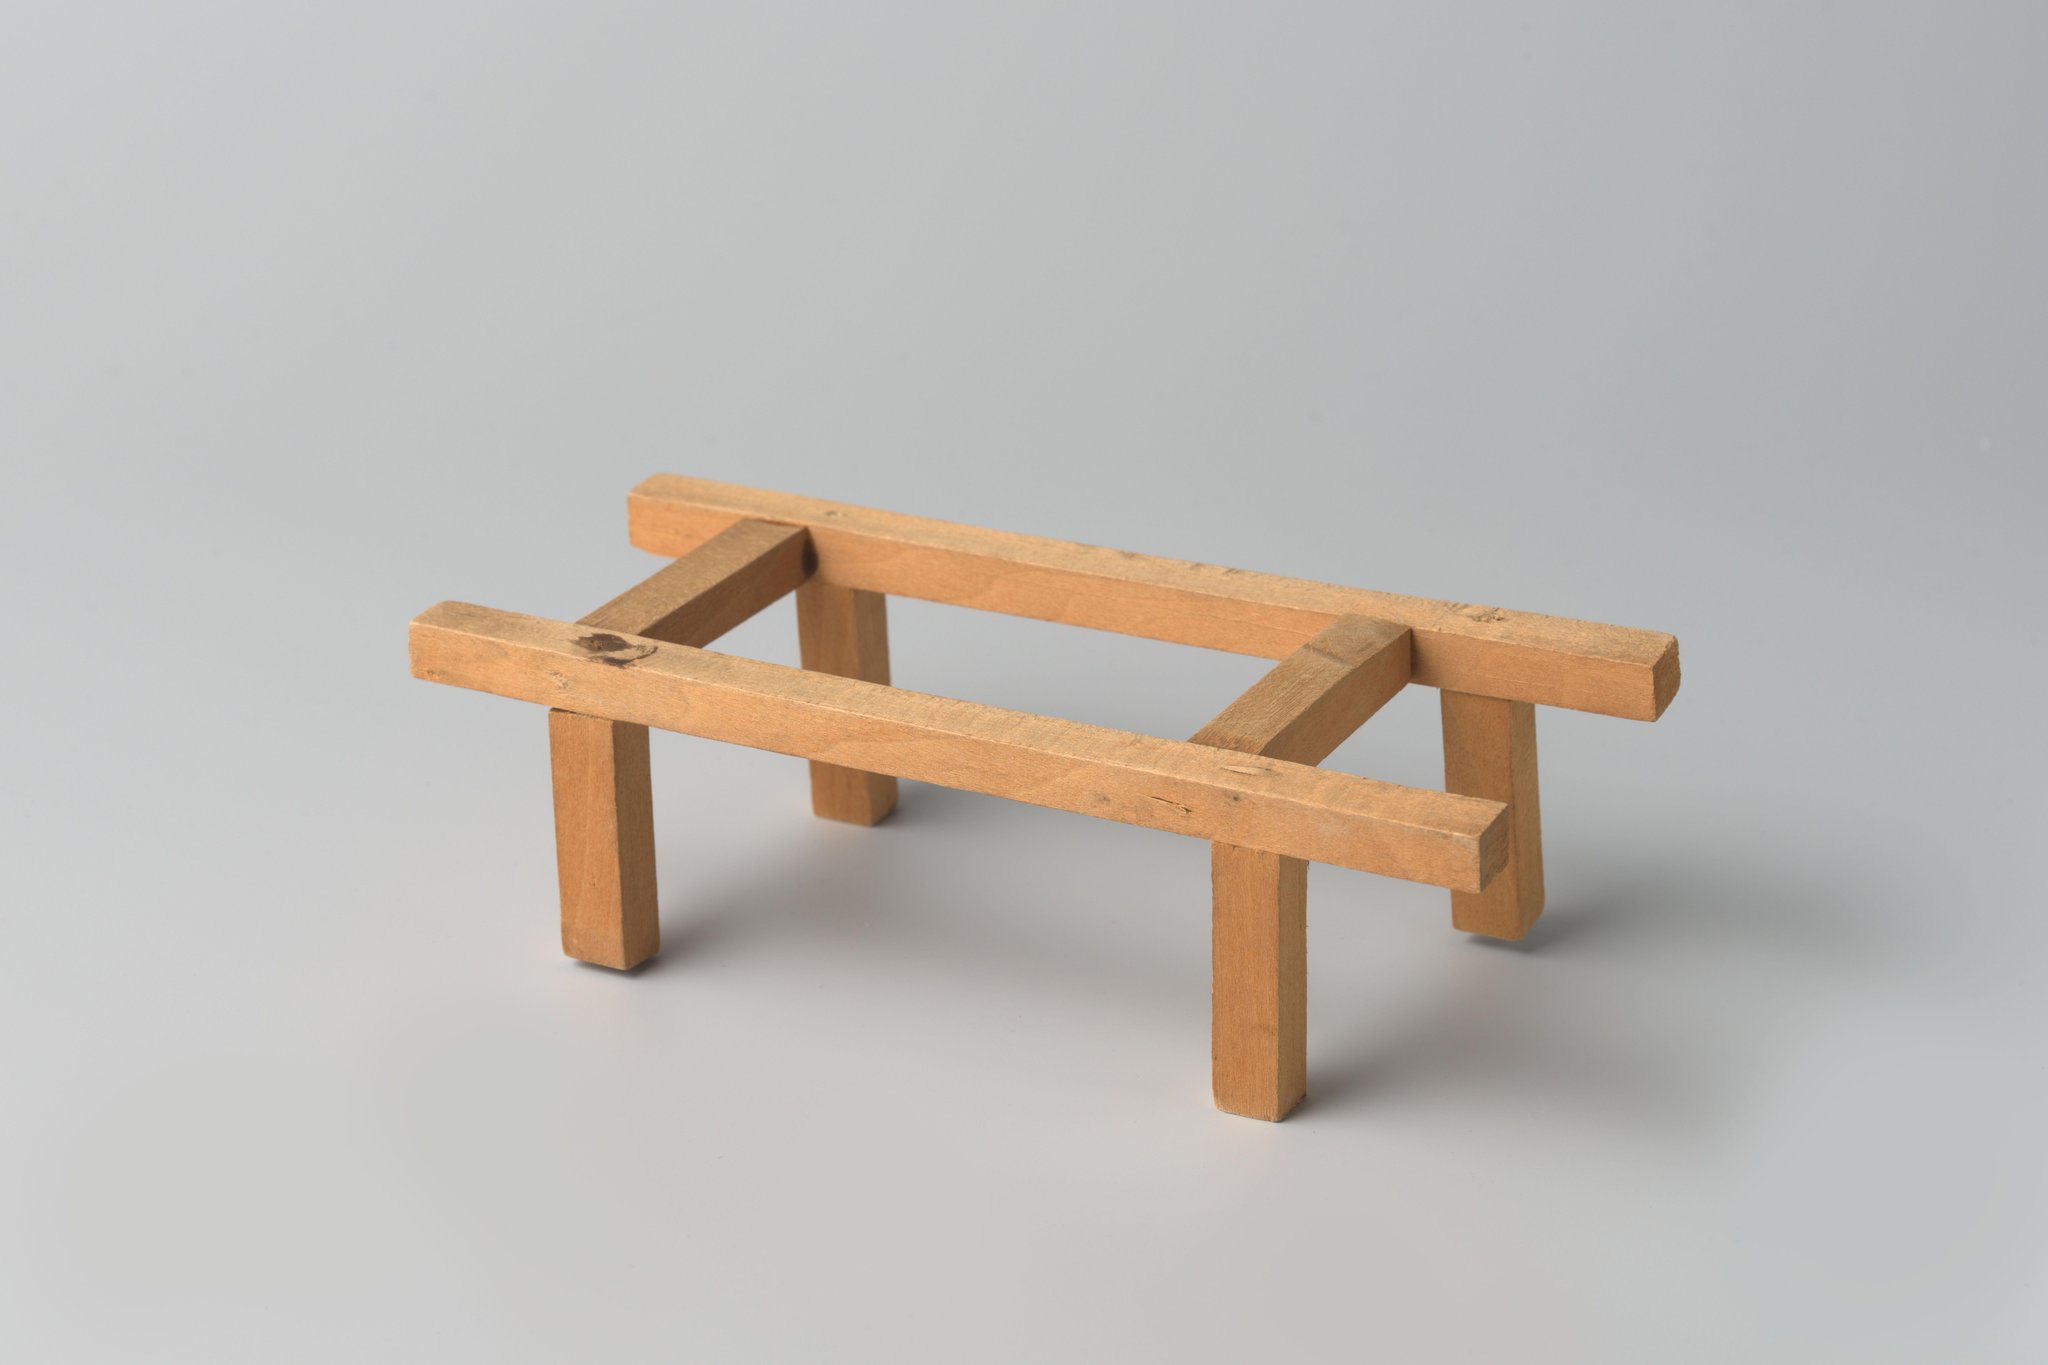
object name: gantry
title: Stelling van lindehout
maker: Anonymous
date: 1676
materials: wood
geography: amsterdam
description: Stelling van lindehout, bestaande uit twee horizontale leggers, twee dwarsregels en rustend op vier poten. De verbindingen met metalen nagels.